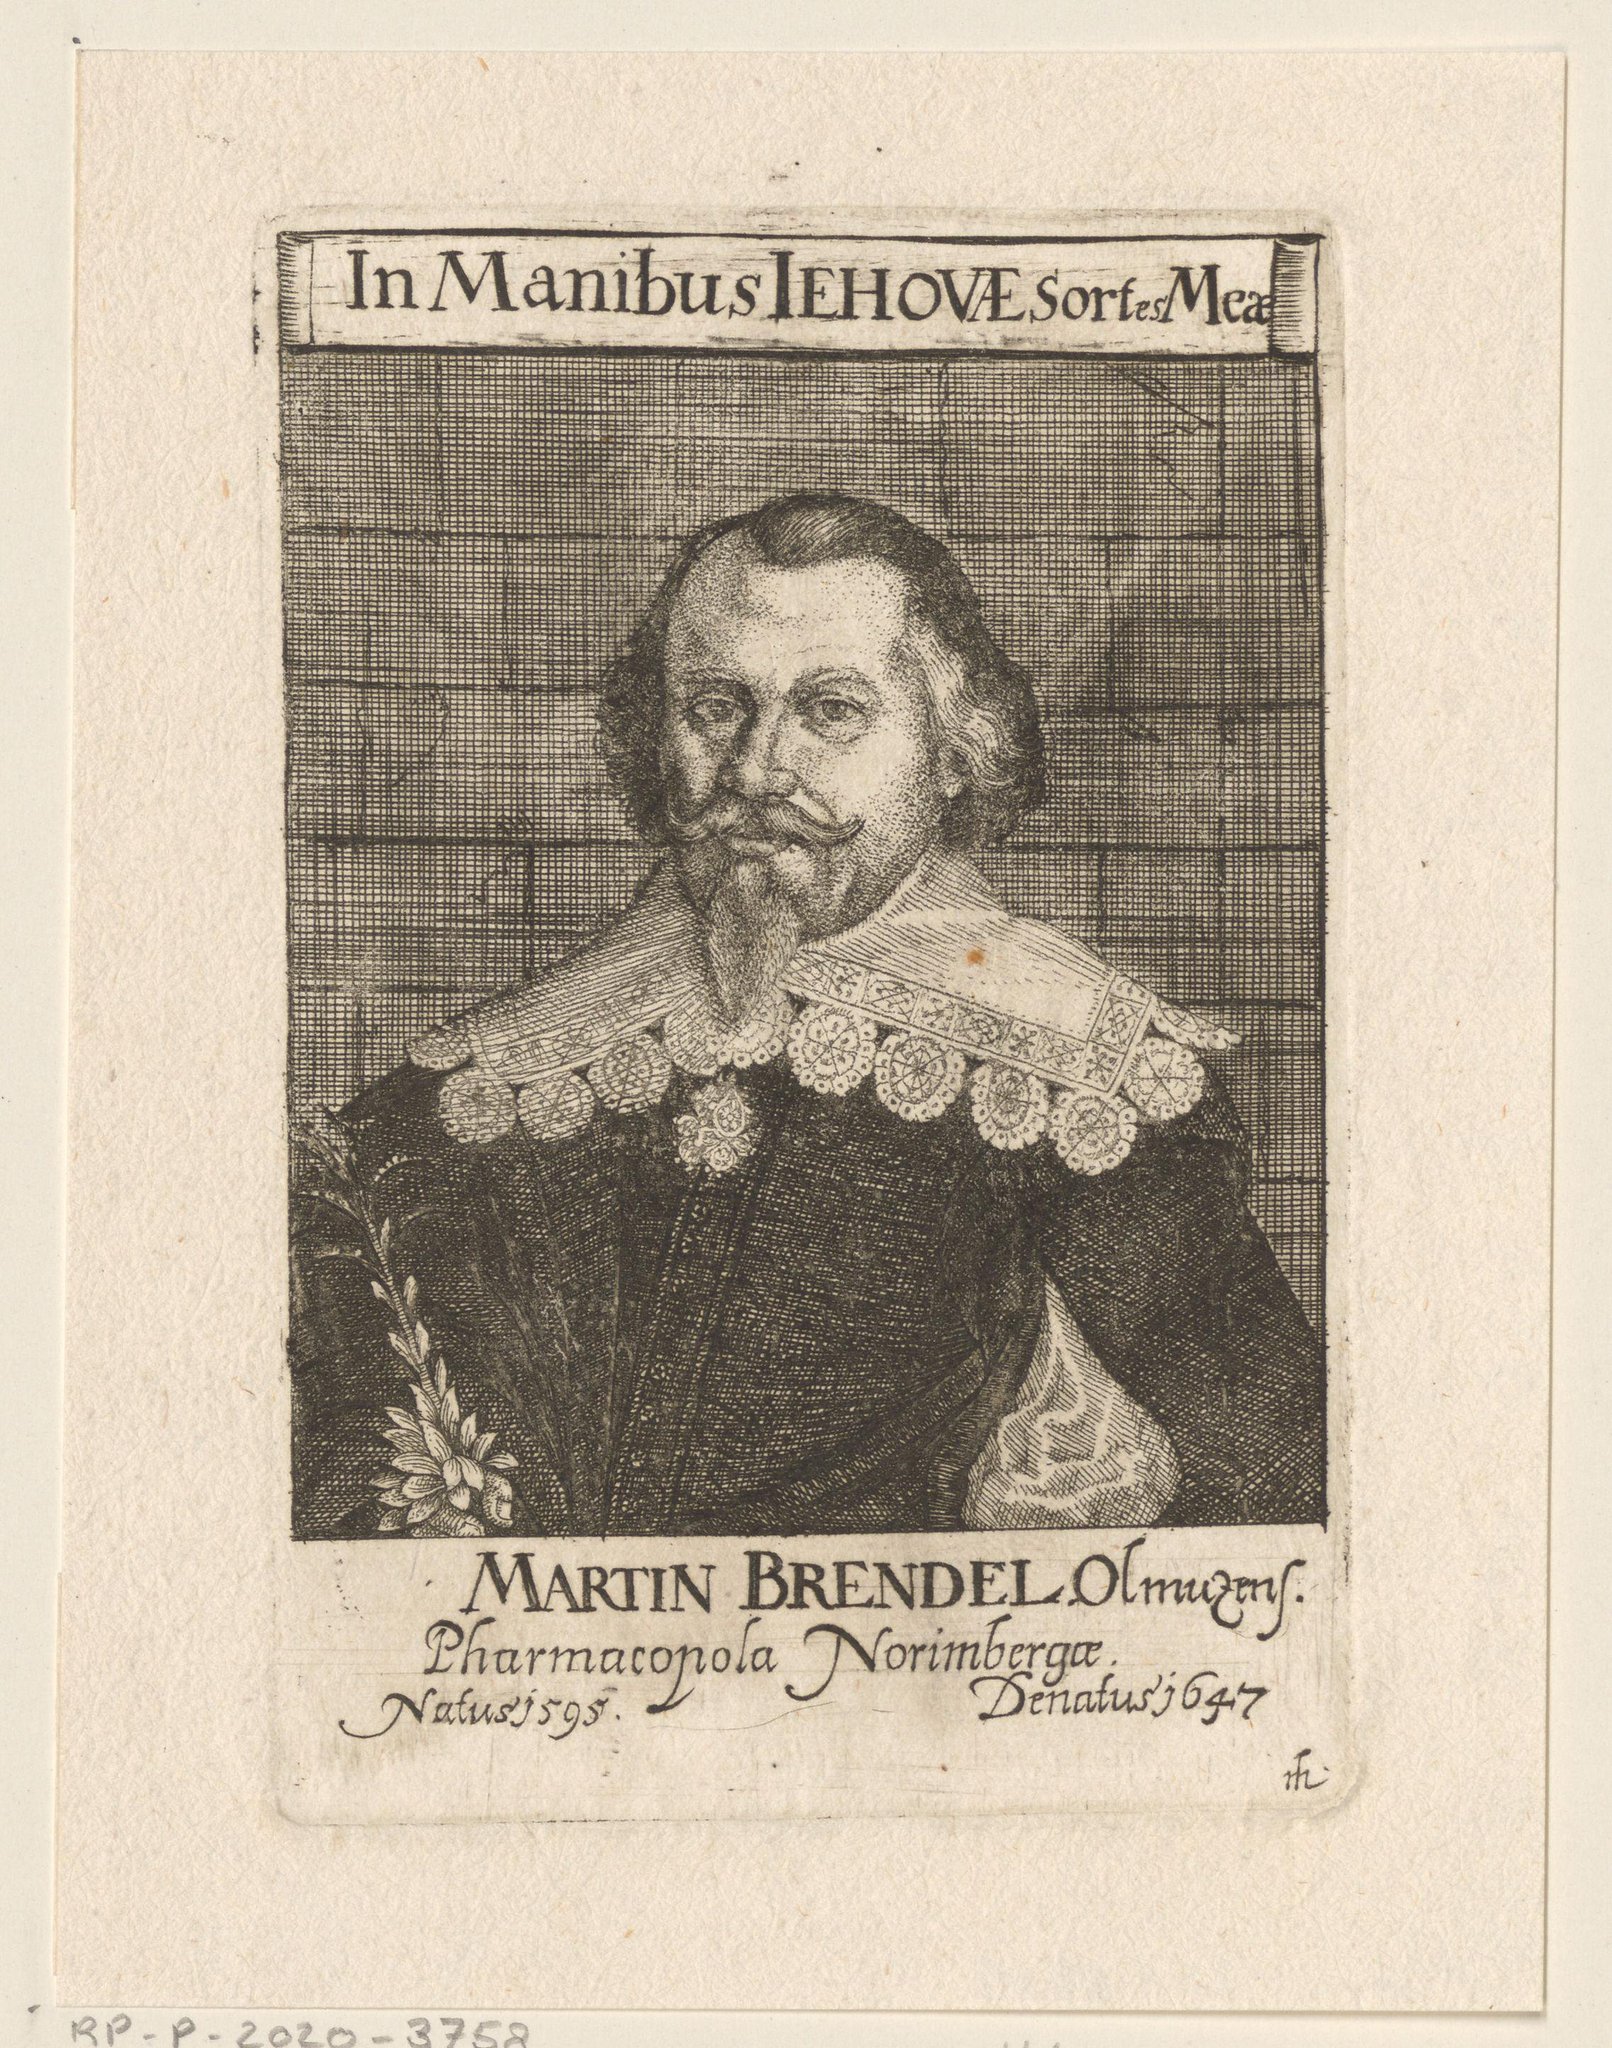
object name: print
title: Portret van Martin Brendel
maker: johann reinhold mühl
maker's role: print maker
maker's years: 1631-1692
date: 1647-1692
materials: paper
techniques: engraving, etching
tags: pharmacist, druggist, apothecary; pharmacy, drugstore, dispensing chemist, historical persons, plants and herbs